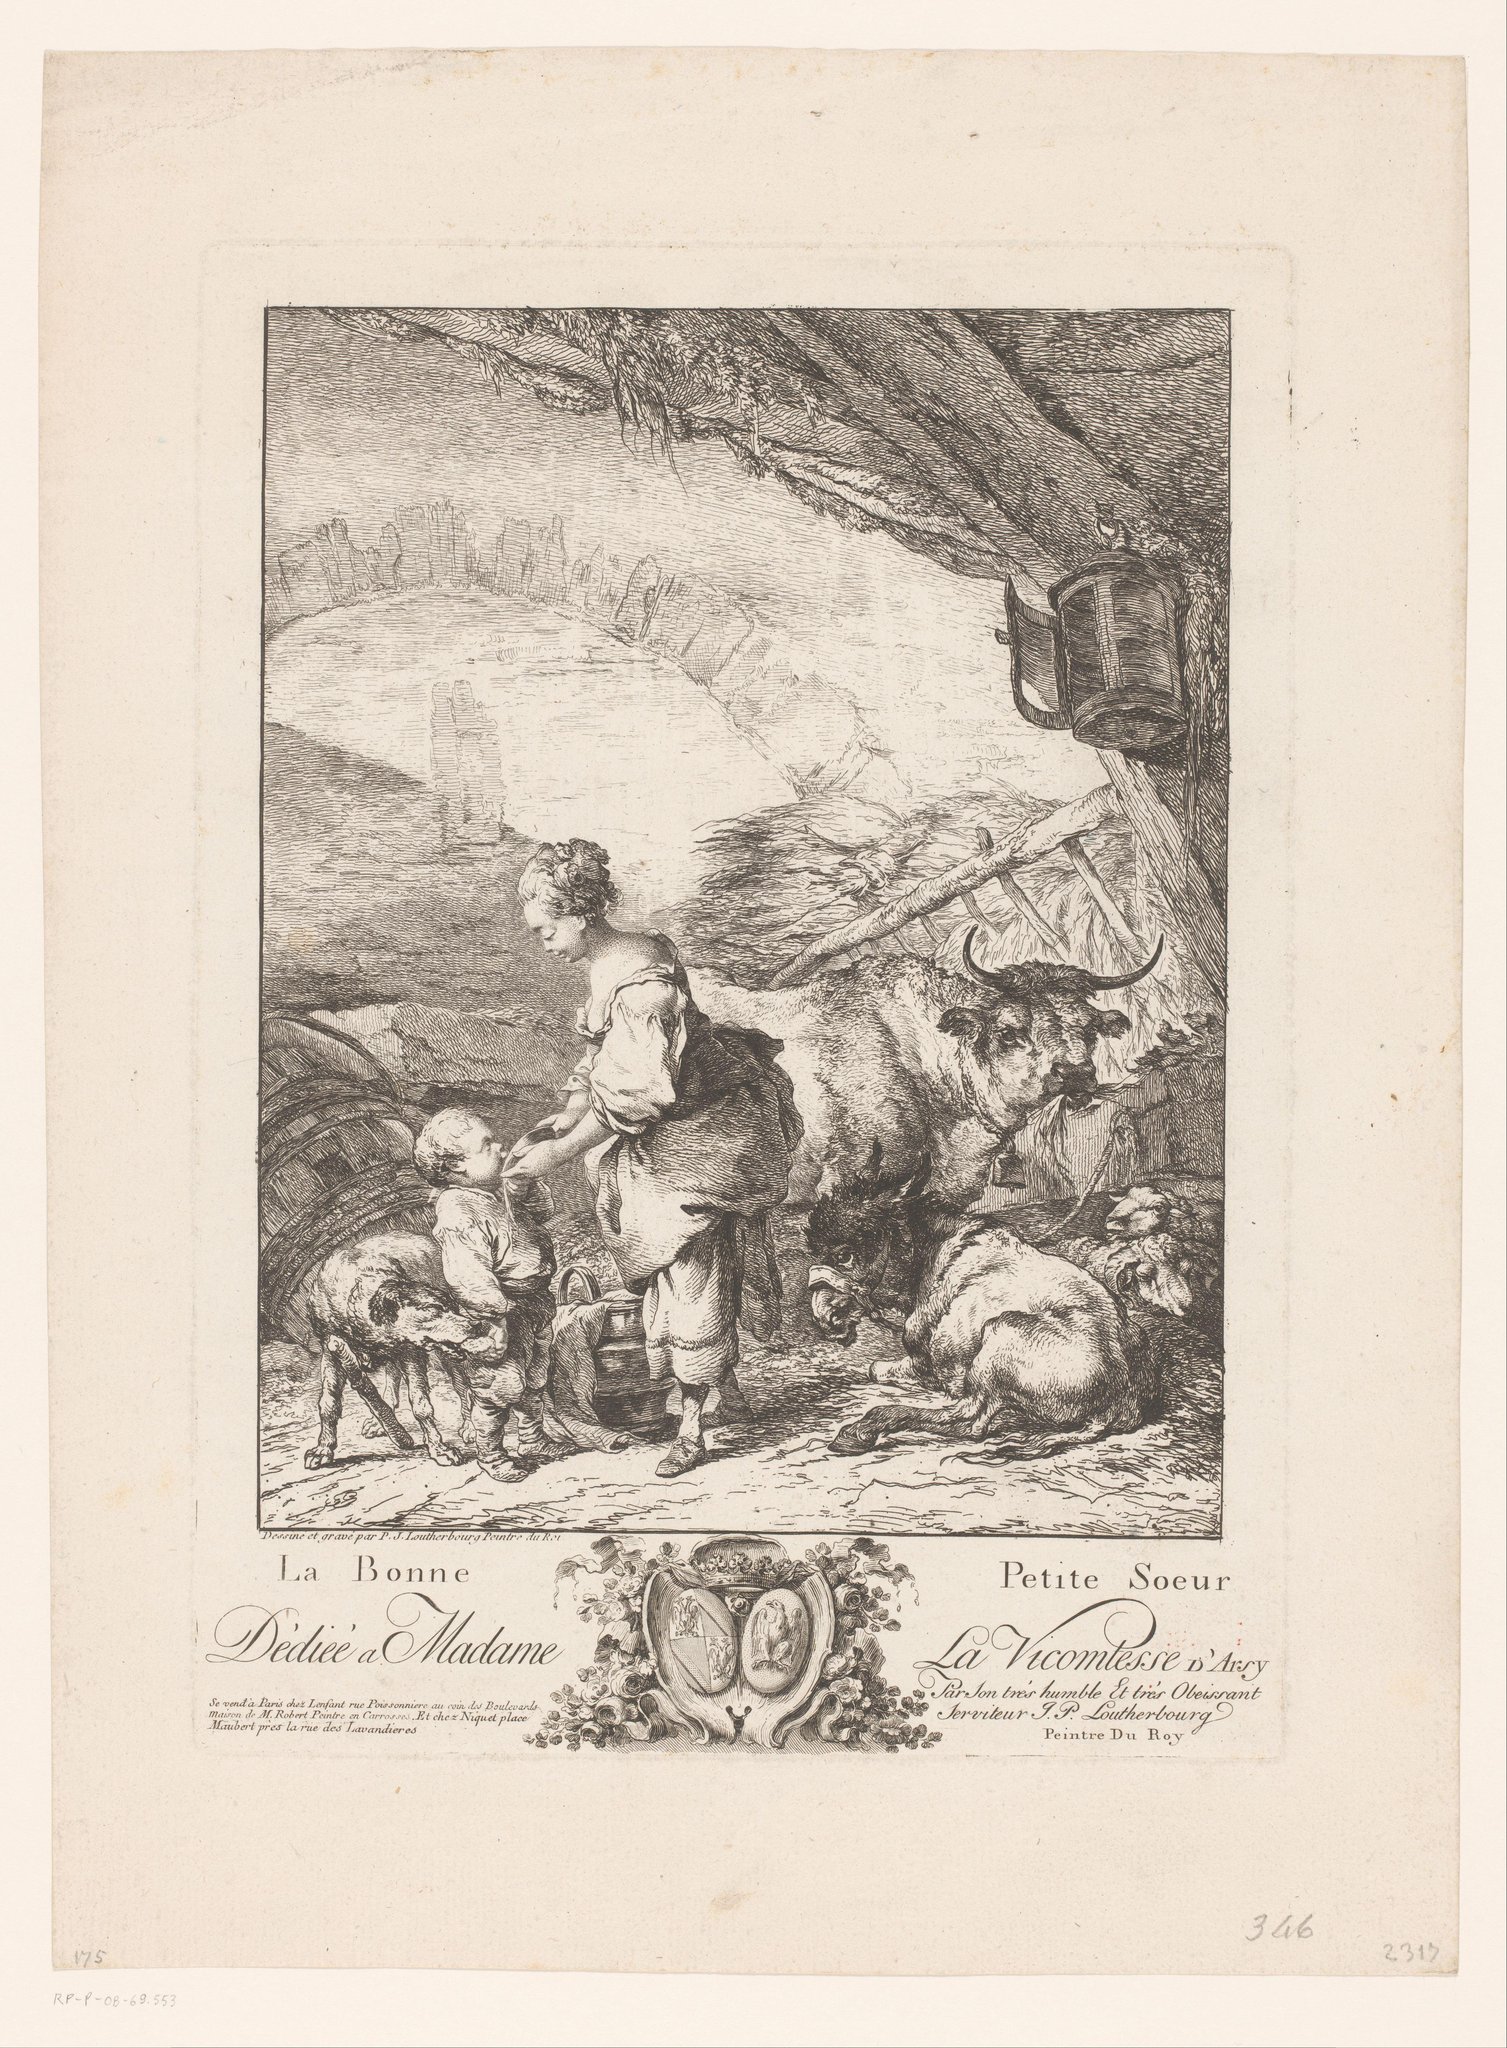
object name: print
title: La Bonne Petite Soeur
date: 1708-1812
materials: paper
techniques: etching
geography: paris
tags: adolescent, young woman, maiden, toddler, stall, stable, armorial bearing, heraldry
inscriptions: collector's mark: Lugt 240